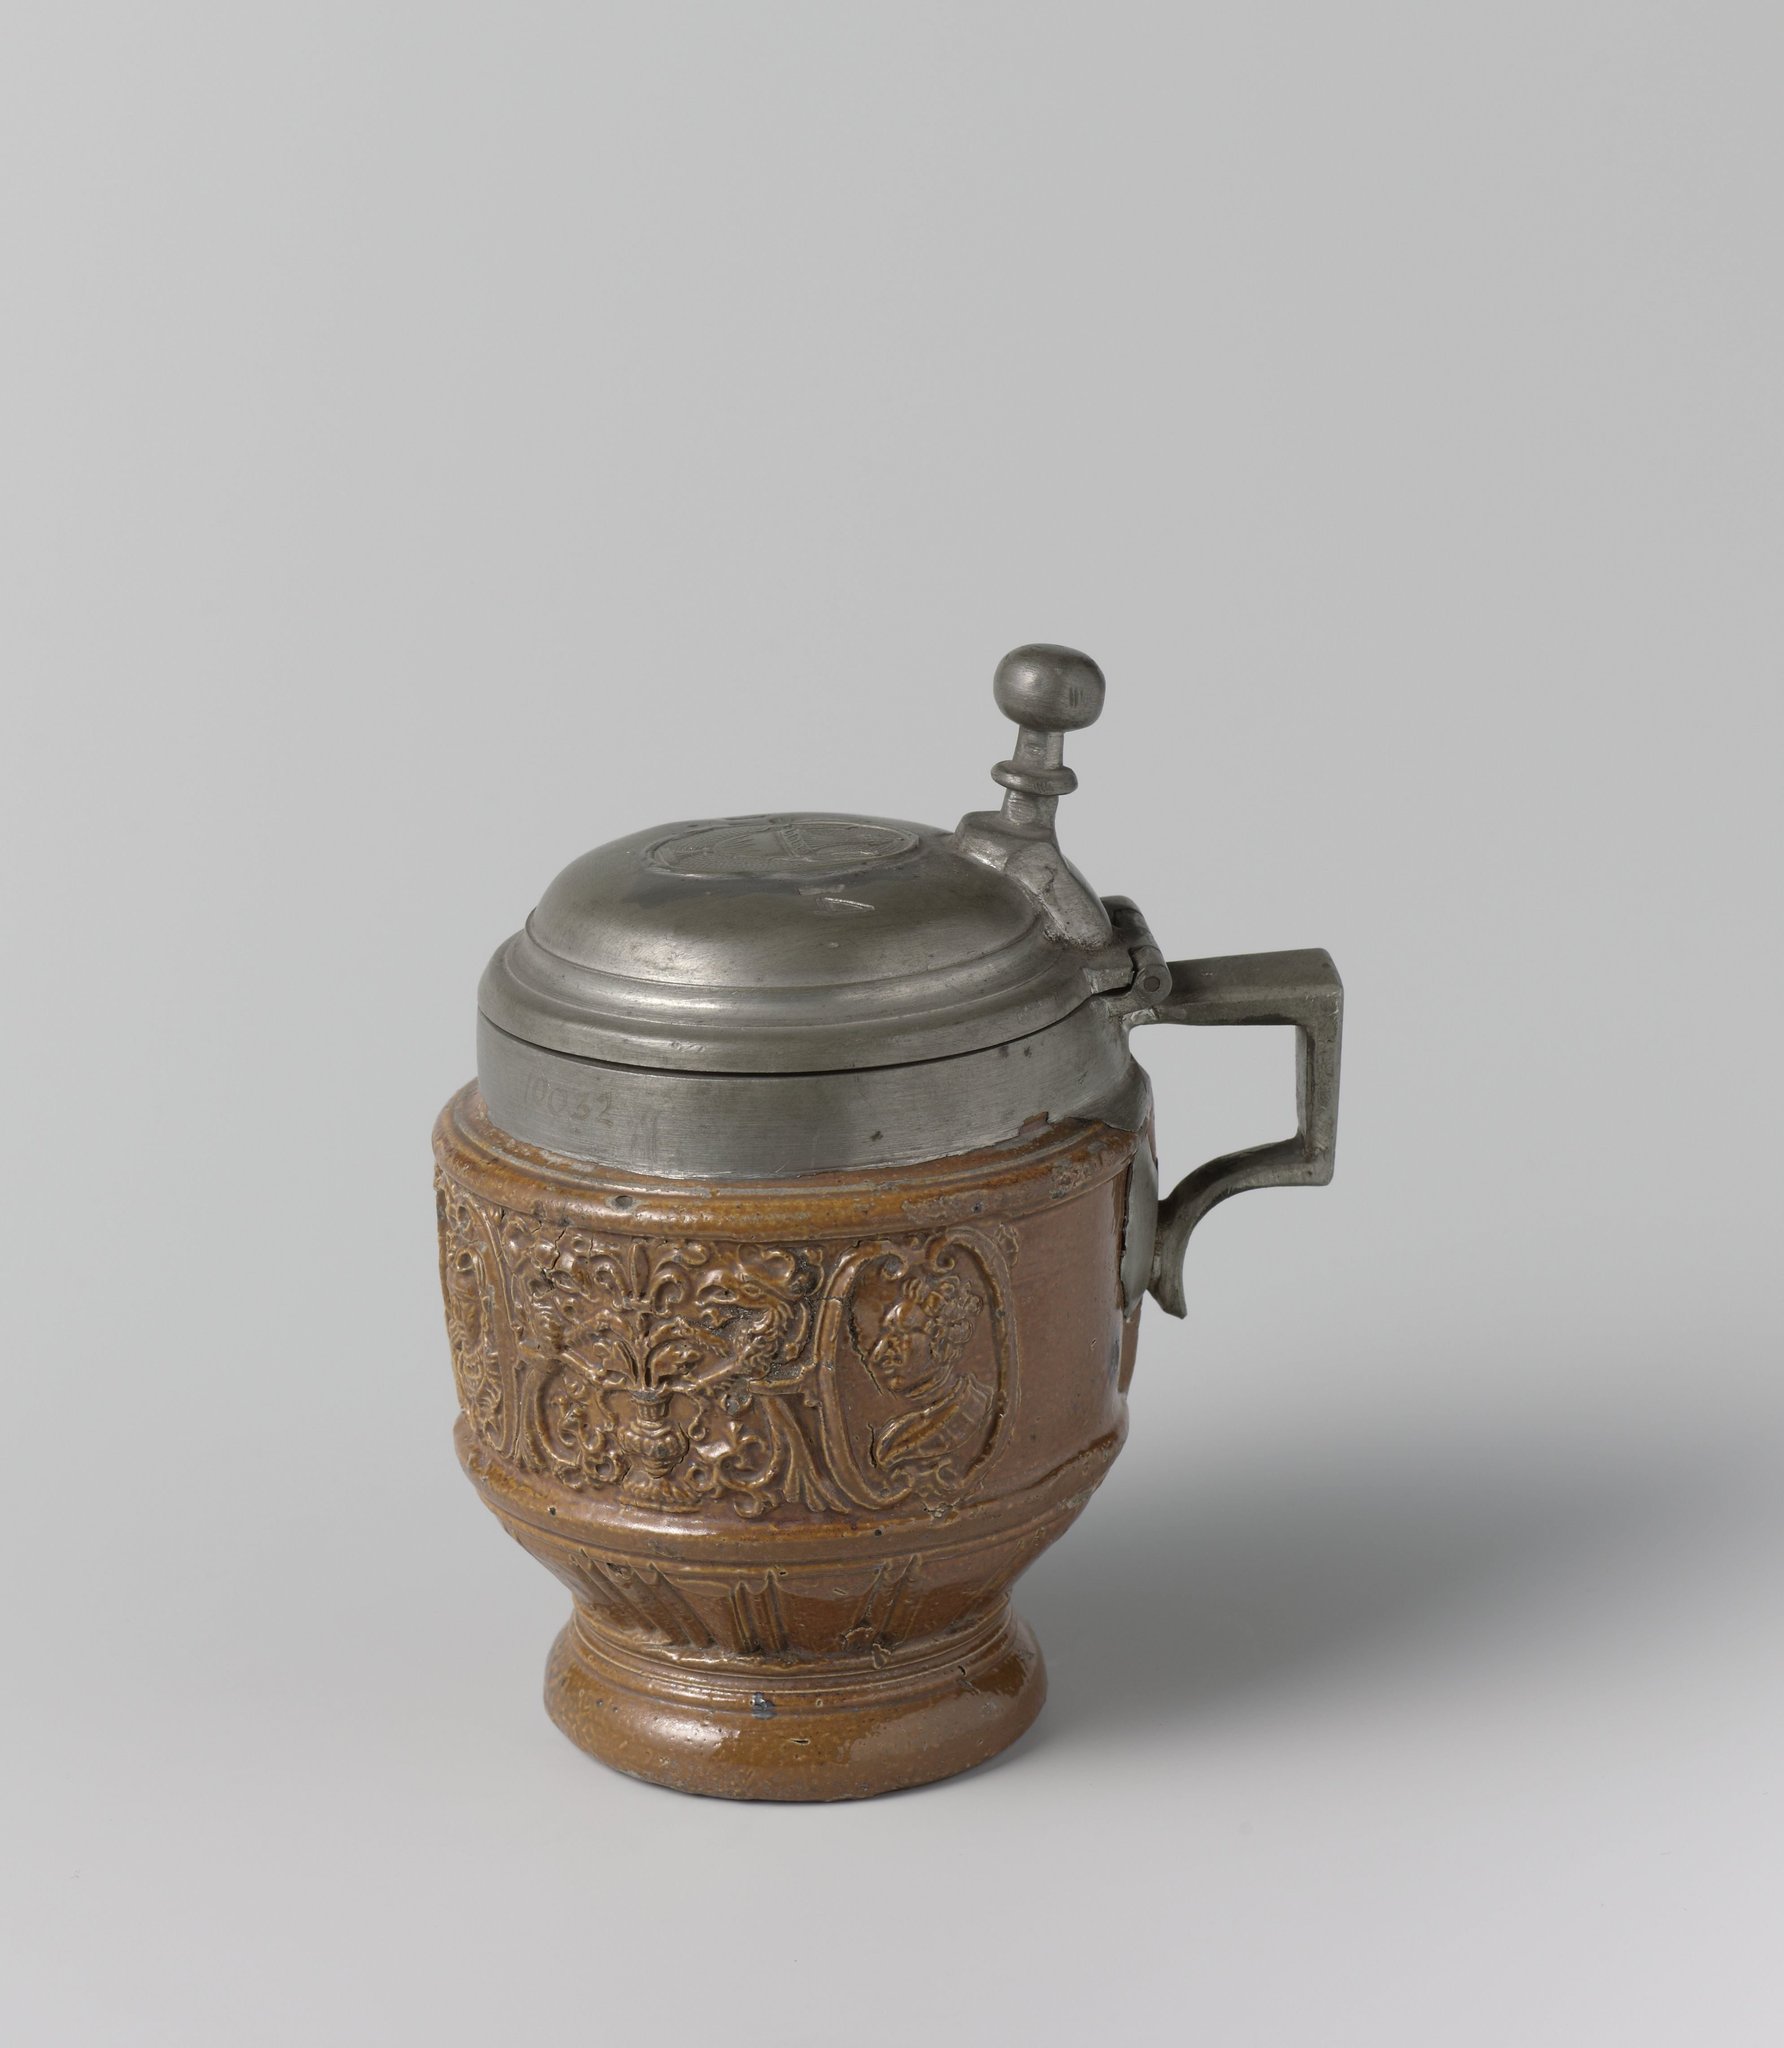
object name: jug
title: Jug with medallions and foliate scrolls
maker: Anonymous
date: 1560-1590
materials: engobe, glaze, stoneware, tin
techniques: firing, forming, relief, turning, vitrification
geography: raeren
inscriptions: date: ‘1714’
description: Kruik van steengoed op hoge voet met een cilindervormig lichaam en korte, wijde nek. Bedekt met een bruine engobe. Op de buik in reliëf een gedrukte en opgelegde decoratie van drie portretten, één en face en twee en profil, met daartussen een vaas met bladranken en vogelkoppen. Het onderste deel van de buik loopt schuin af en is verdeeld in vakken. De rand is omvat in een tinnen montuur van later datum met deksel en oor. Op het deksel een medaillon met een vaas en het jaartal '1714'. Raeren.